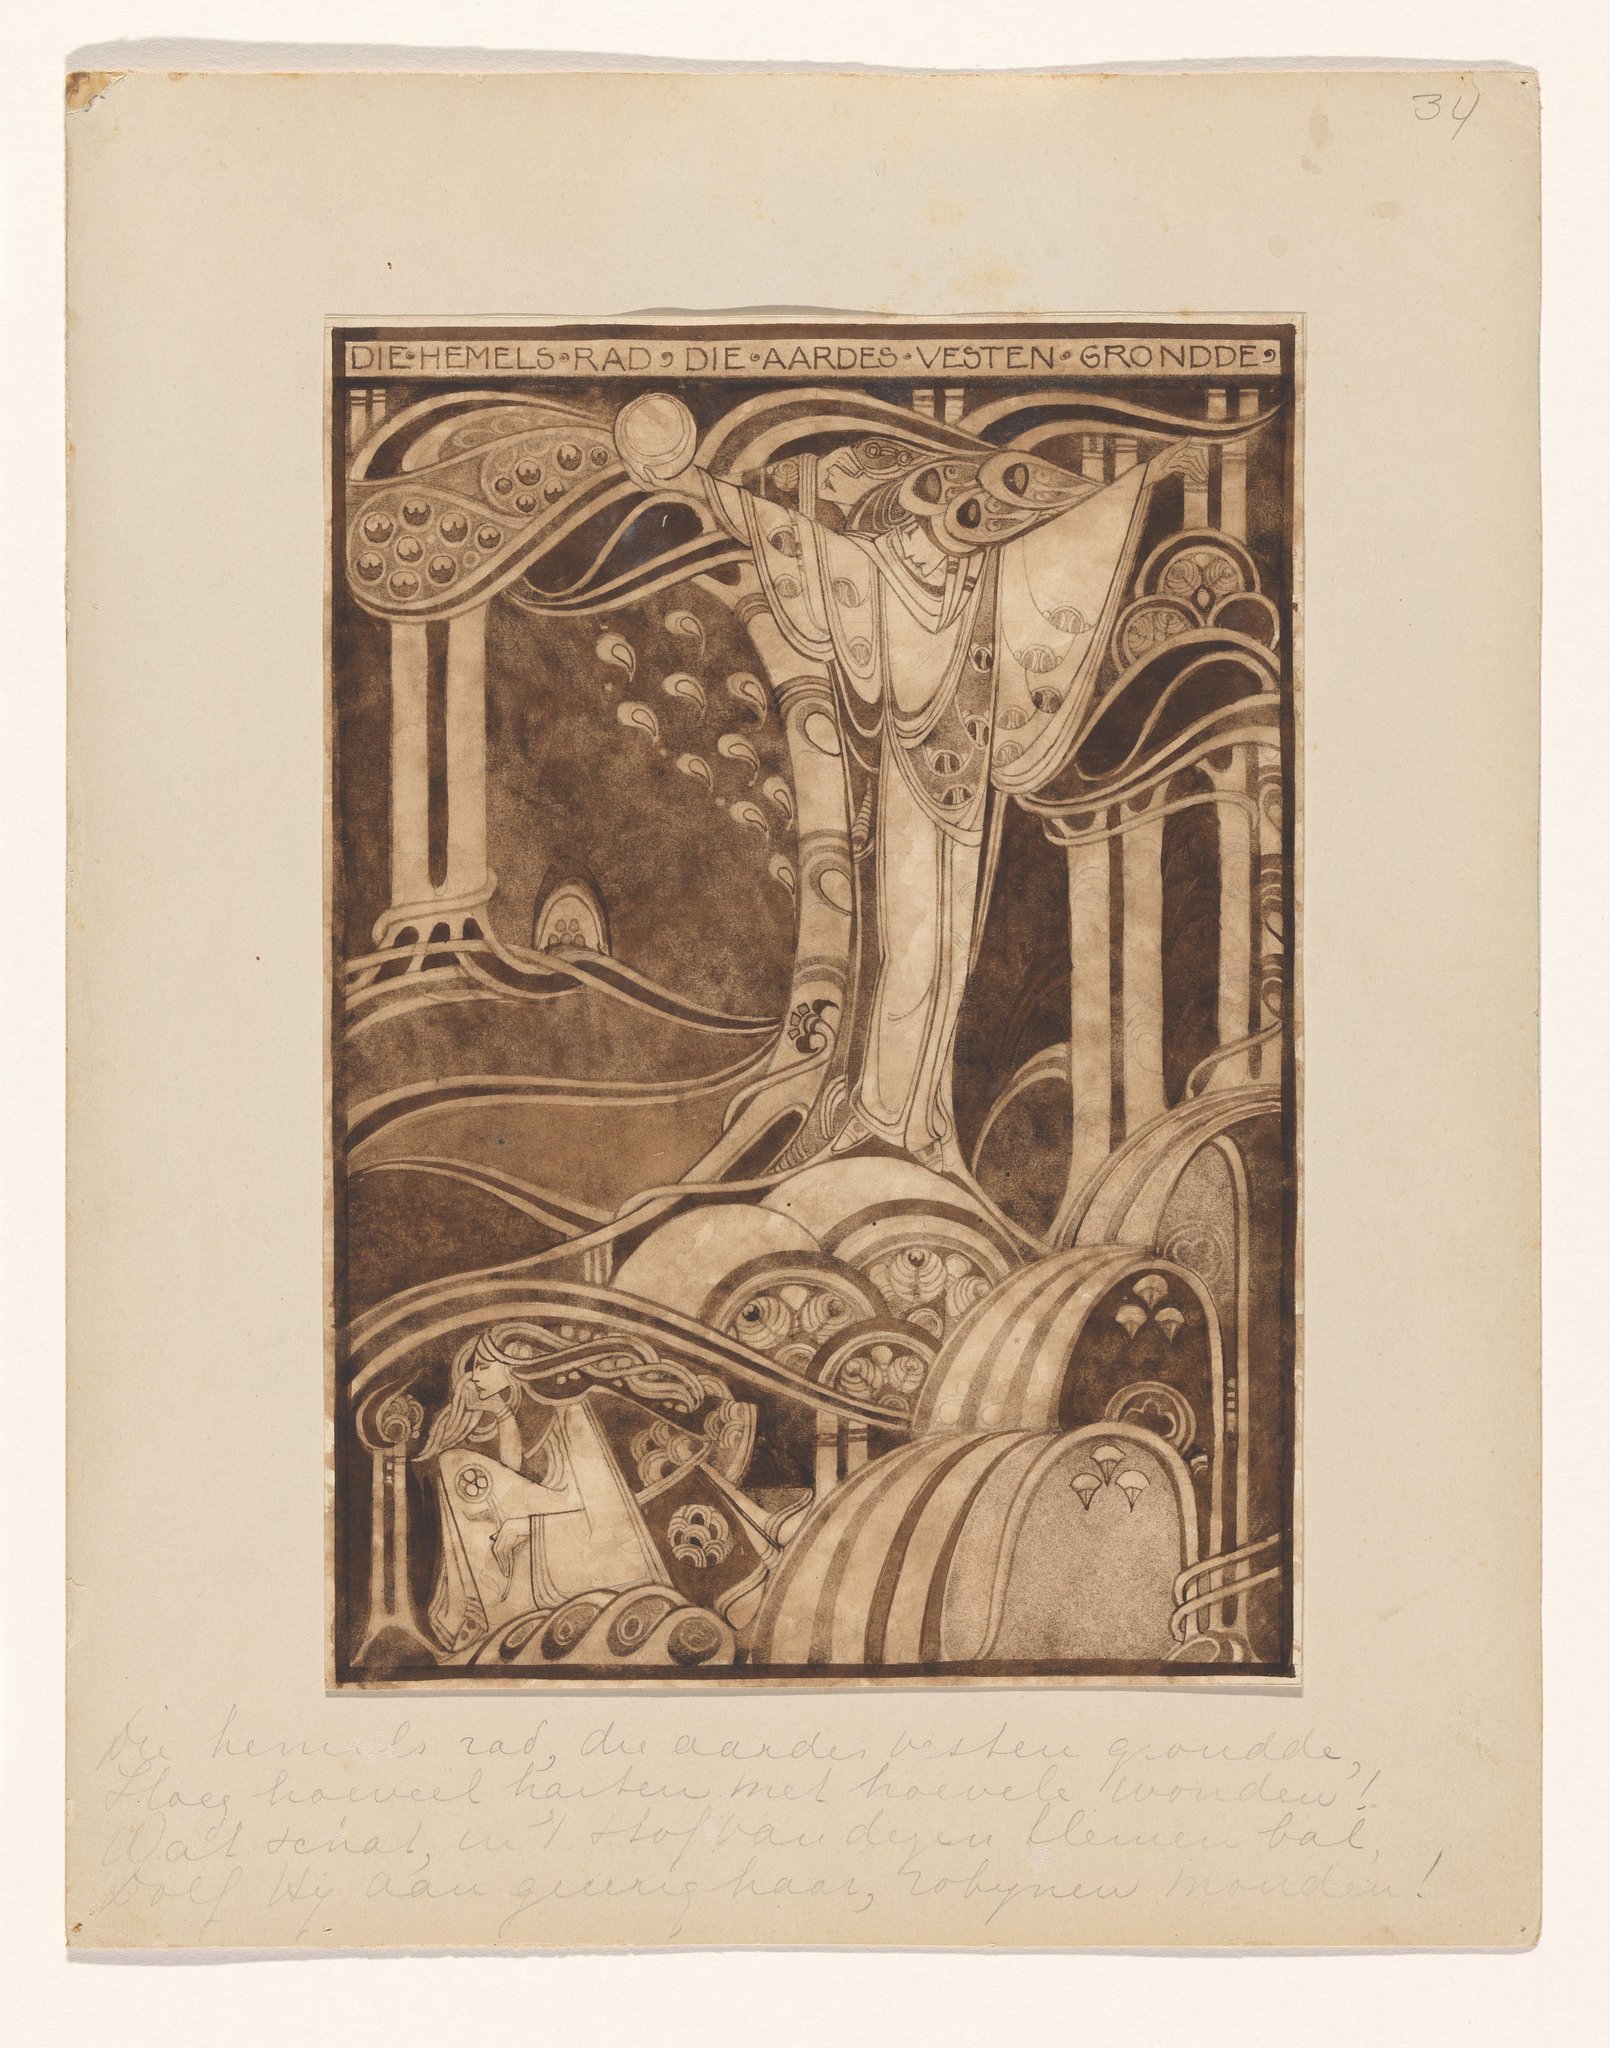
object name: drawing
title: Die hemels rad, die aardes vesten grondde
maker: willem arondéus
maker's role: draughtsman, print maker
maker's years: 1894-1943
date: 1914-1920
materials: cardboard, ink, paper, pencil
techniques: brush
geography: netherlands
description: Tekening naar de Rubaiyat van Omar Khayyam.